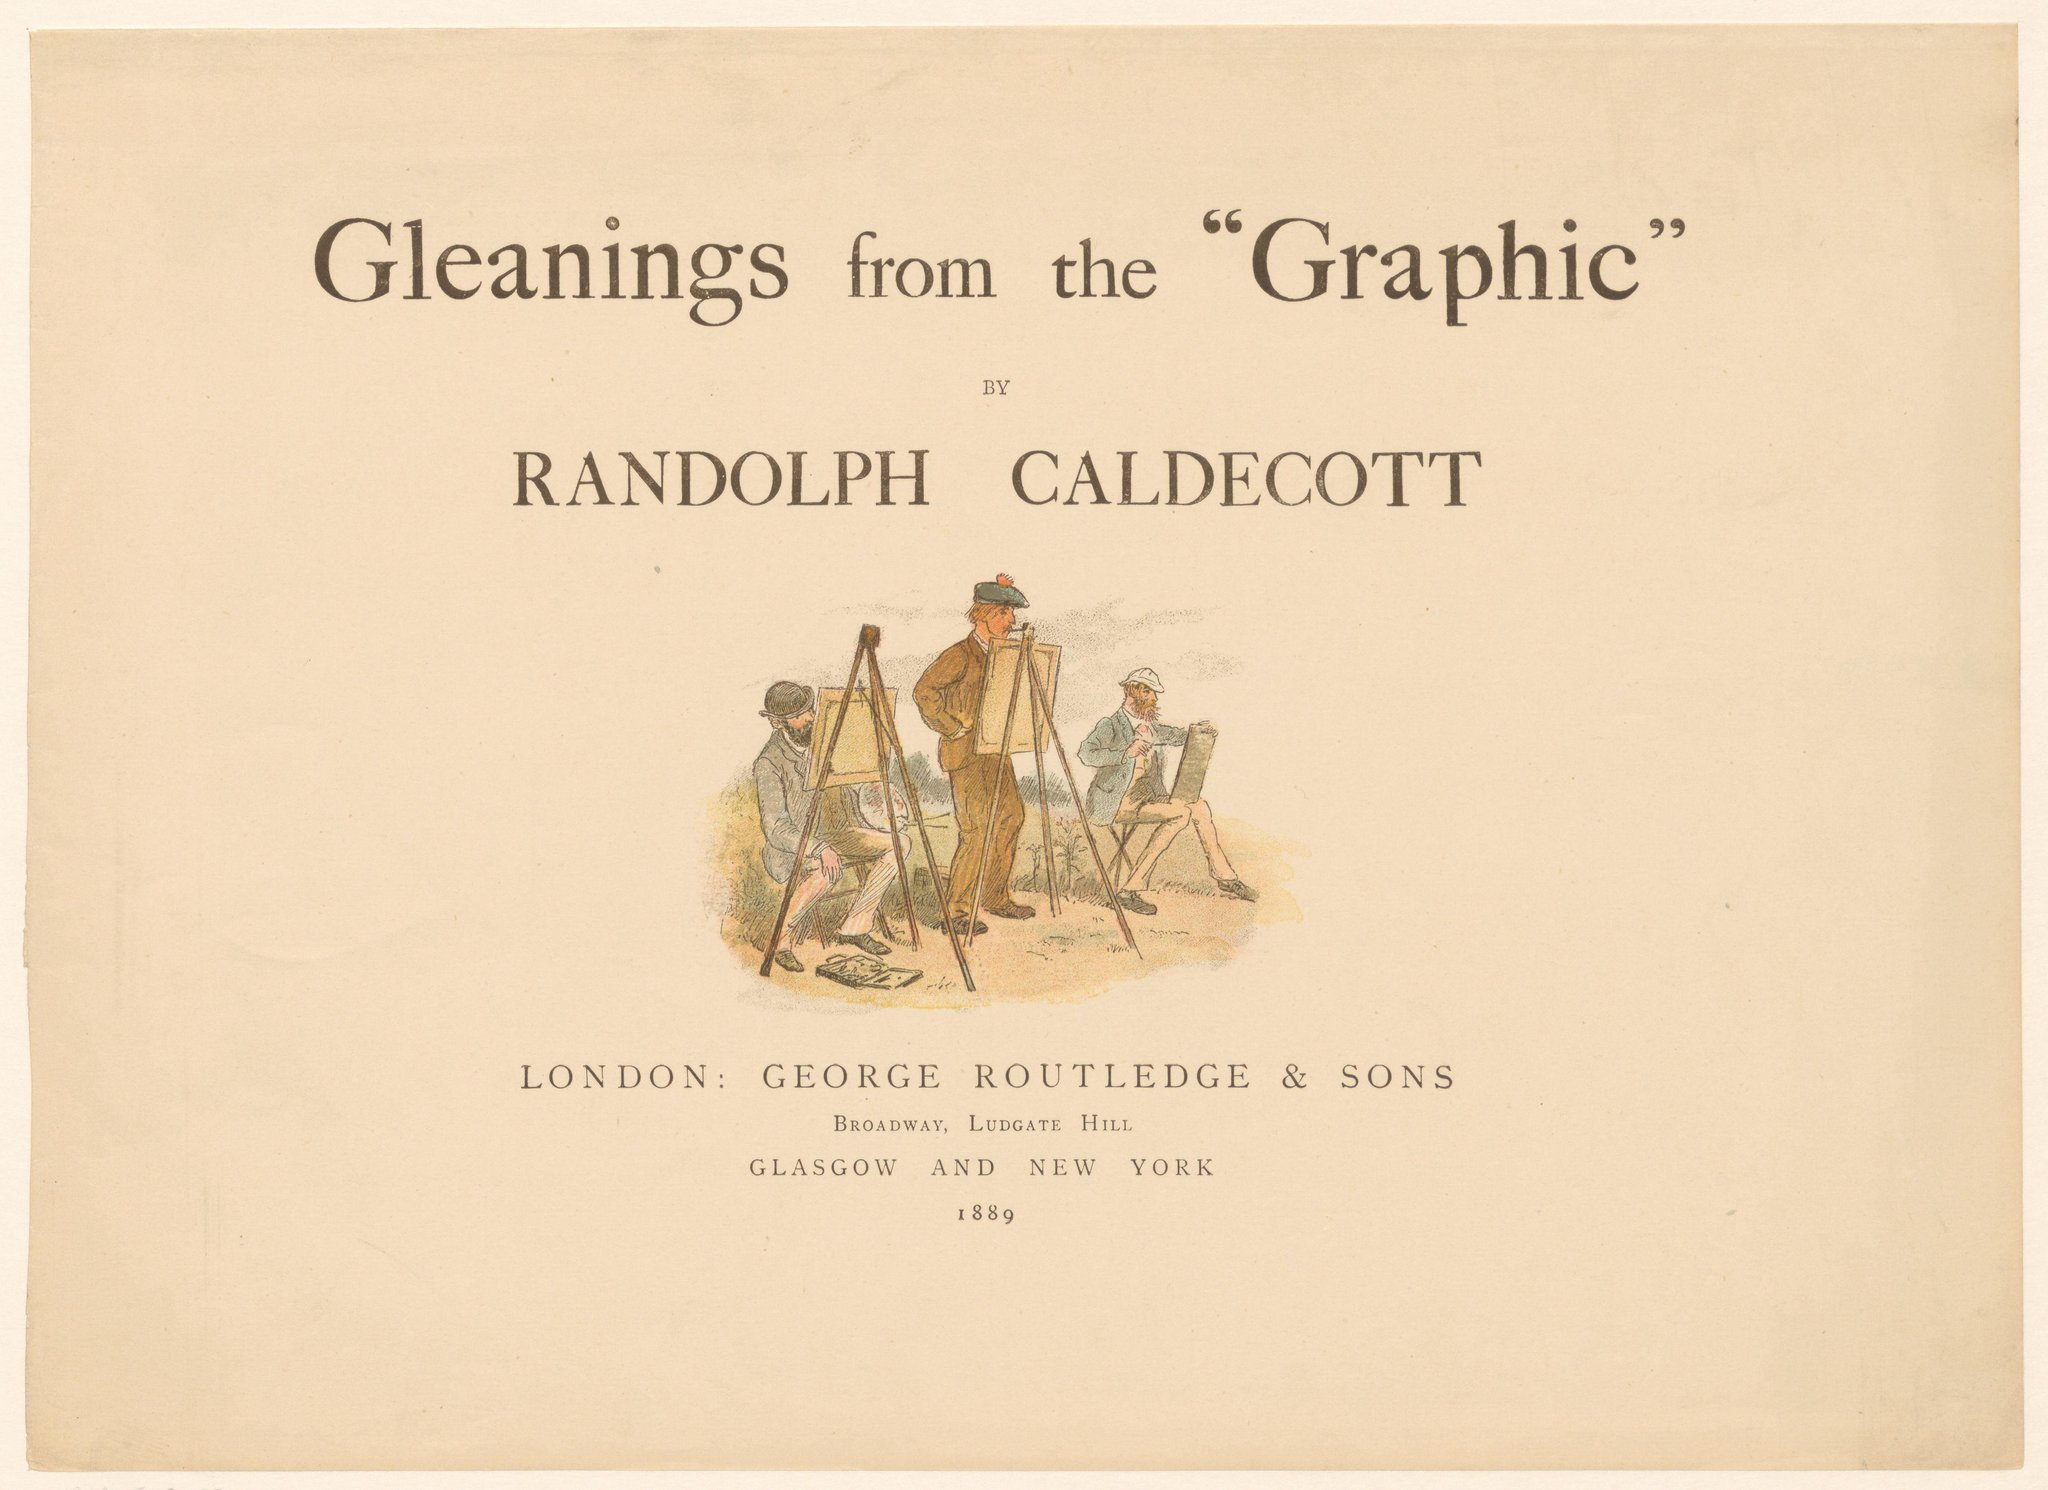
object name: titelblad, titelpagina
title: Titelpagina voor: Randolph Caldecott, Gleanings from the Graphic, 1889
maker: randolph caldecott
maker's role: painter, print maker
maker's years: 1846-1886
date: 1889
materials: paper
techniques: woodcut, letterpress printing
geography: london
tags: working situations ~ painter - cc - out of doors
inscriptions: collector's mark: Lugt 2166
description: Titelpagina voor: Caldecott, Randolph. Gleanings from the Graphic. Londen: George Routledge & Sons, 1889.